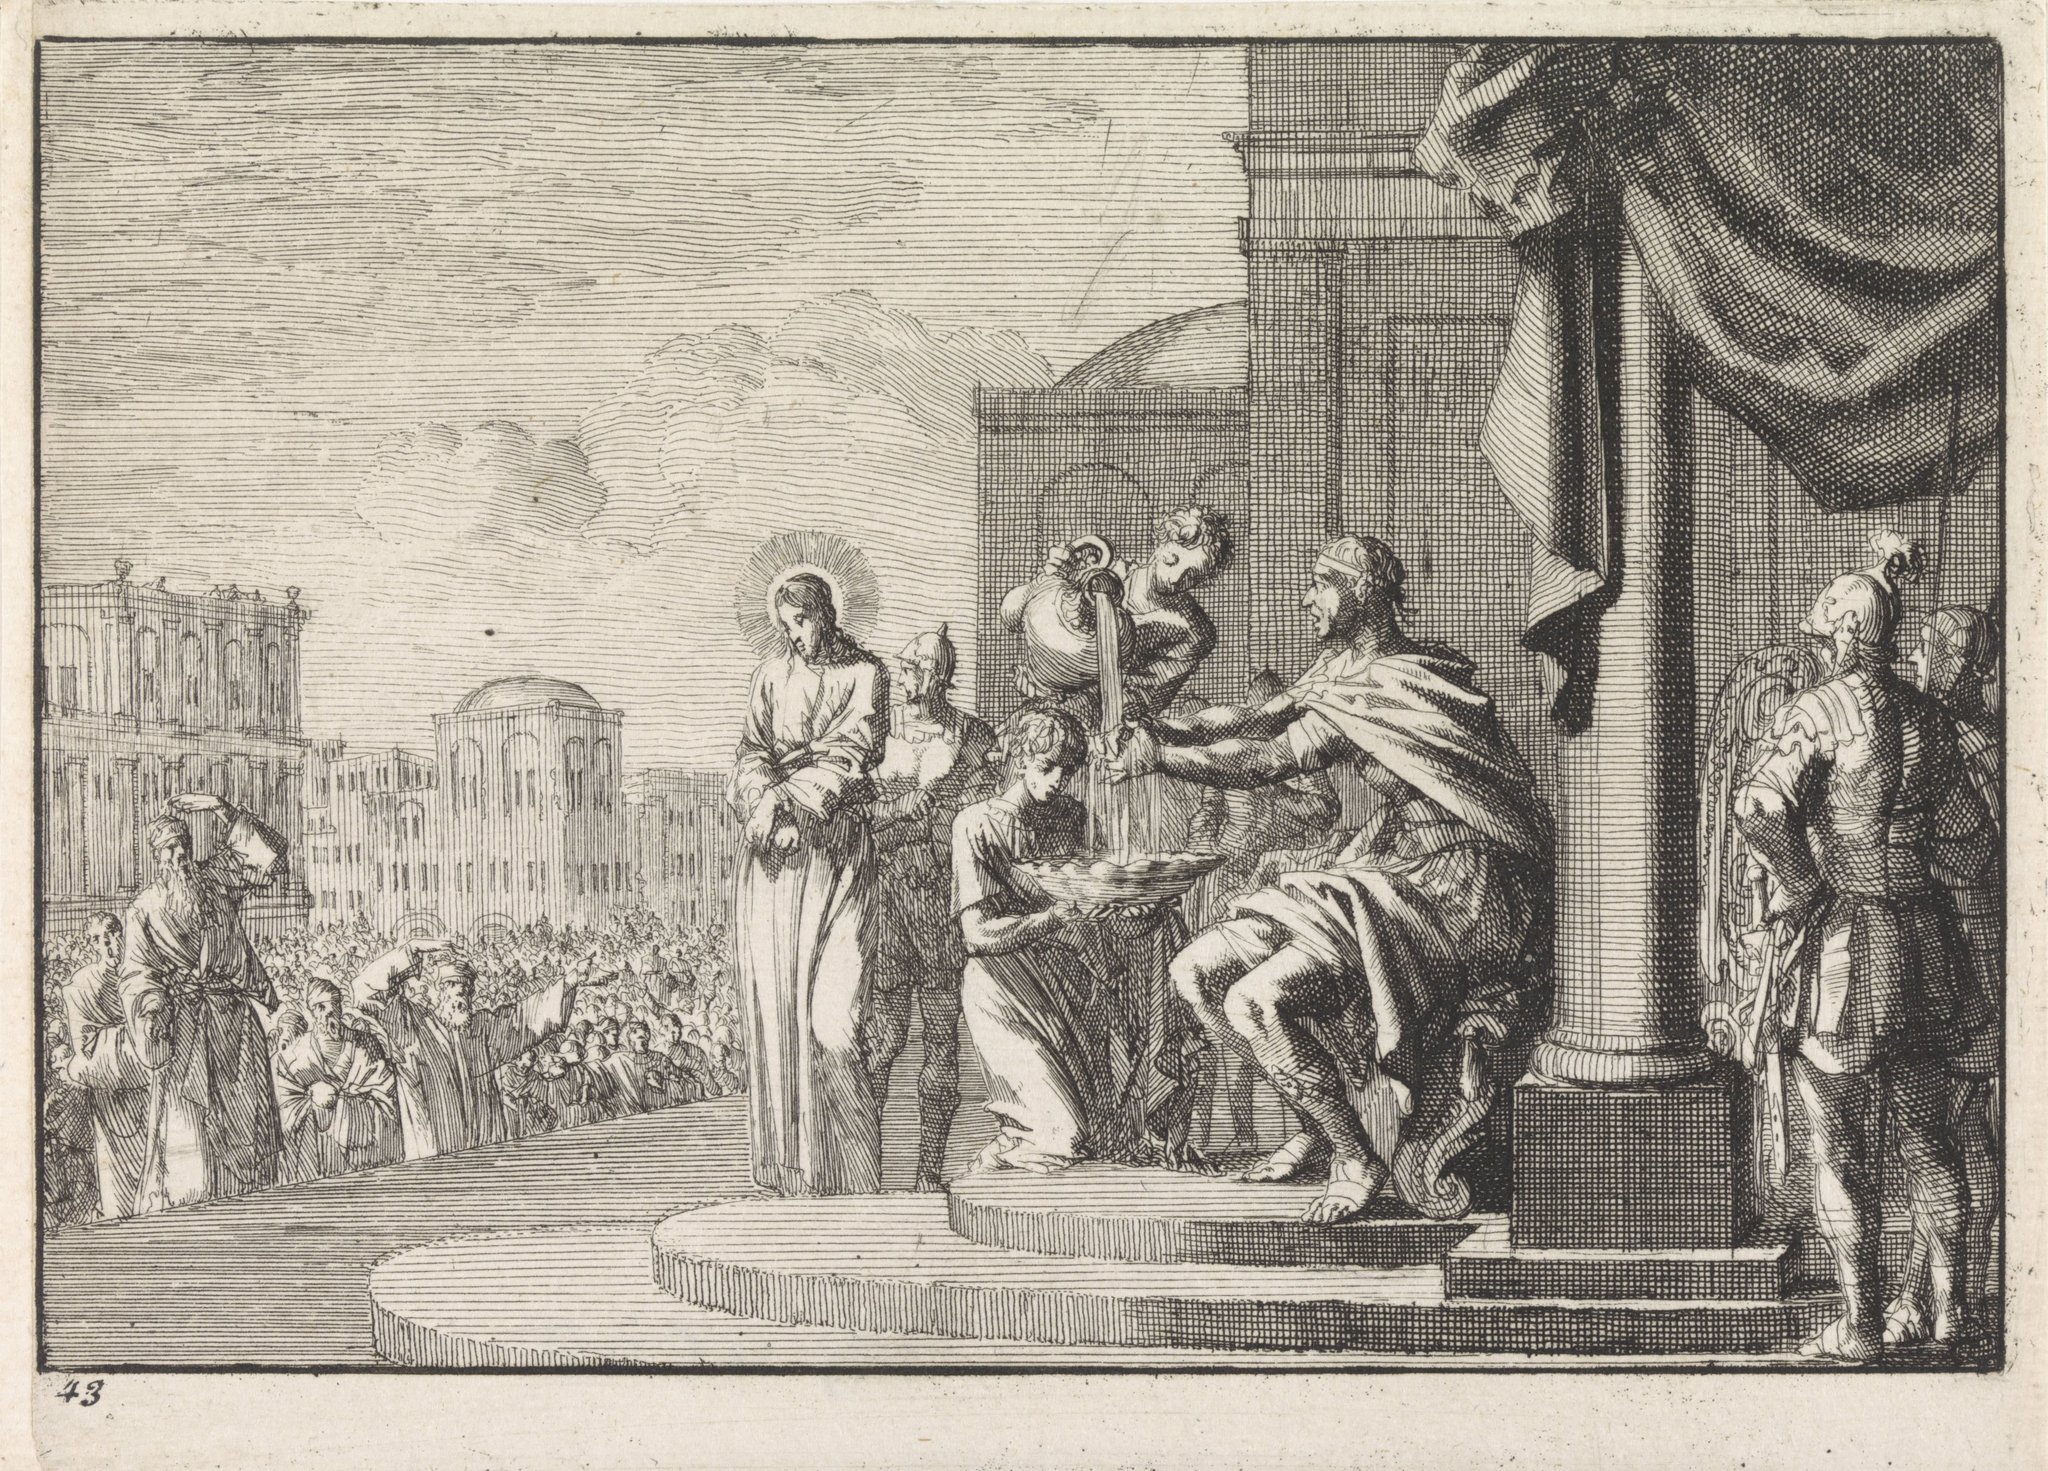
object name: print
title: Pilatus wast zijn handen in onschuld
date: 1703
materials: paper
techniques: etching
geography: haarlem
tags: pilate washing his hands (in innocence)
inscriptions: collector's mark: Lugt 2228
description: Proefdruk van een boekillustratie voor David Martin. Historie des Ouden en Nieuwen Testaments. Amsterdam, Pieter Mortier, 1703. Deel II. De boekillustraties voor de Mortierbijbel hebben verschillende staten en kopieën, waarbij de chronologische volgorde moeilijk te achterhalen valt. Als boekillustraties werden ze bovendien herhaaldelijk opnieuw gebruikt voor andere boekwerken.